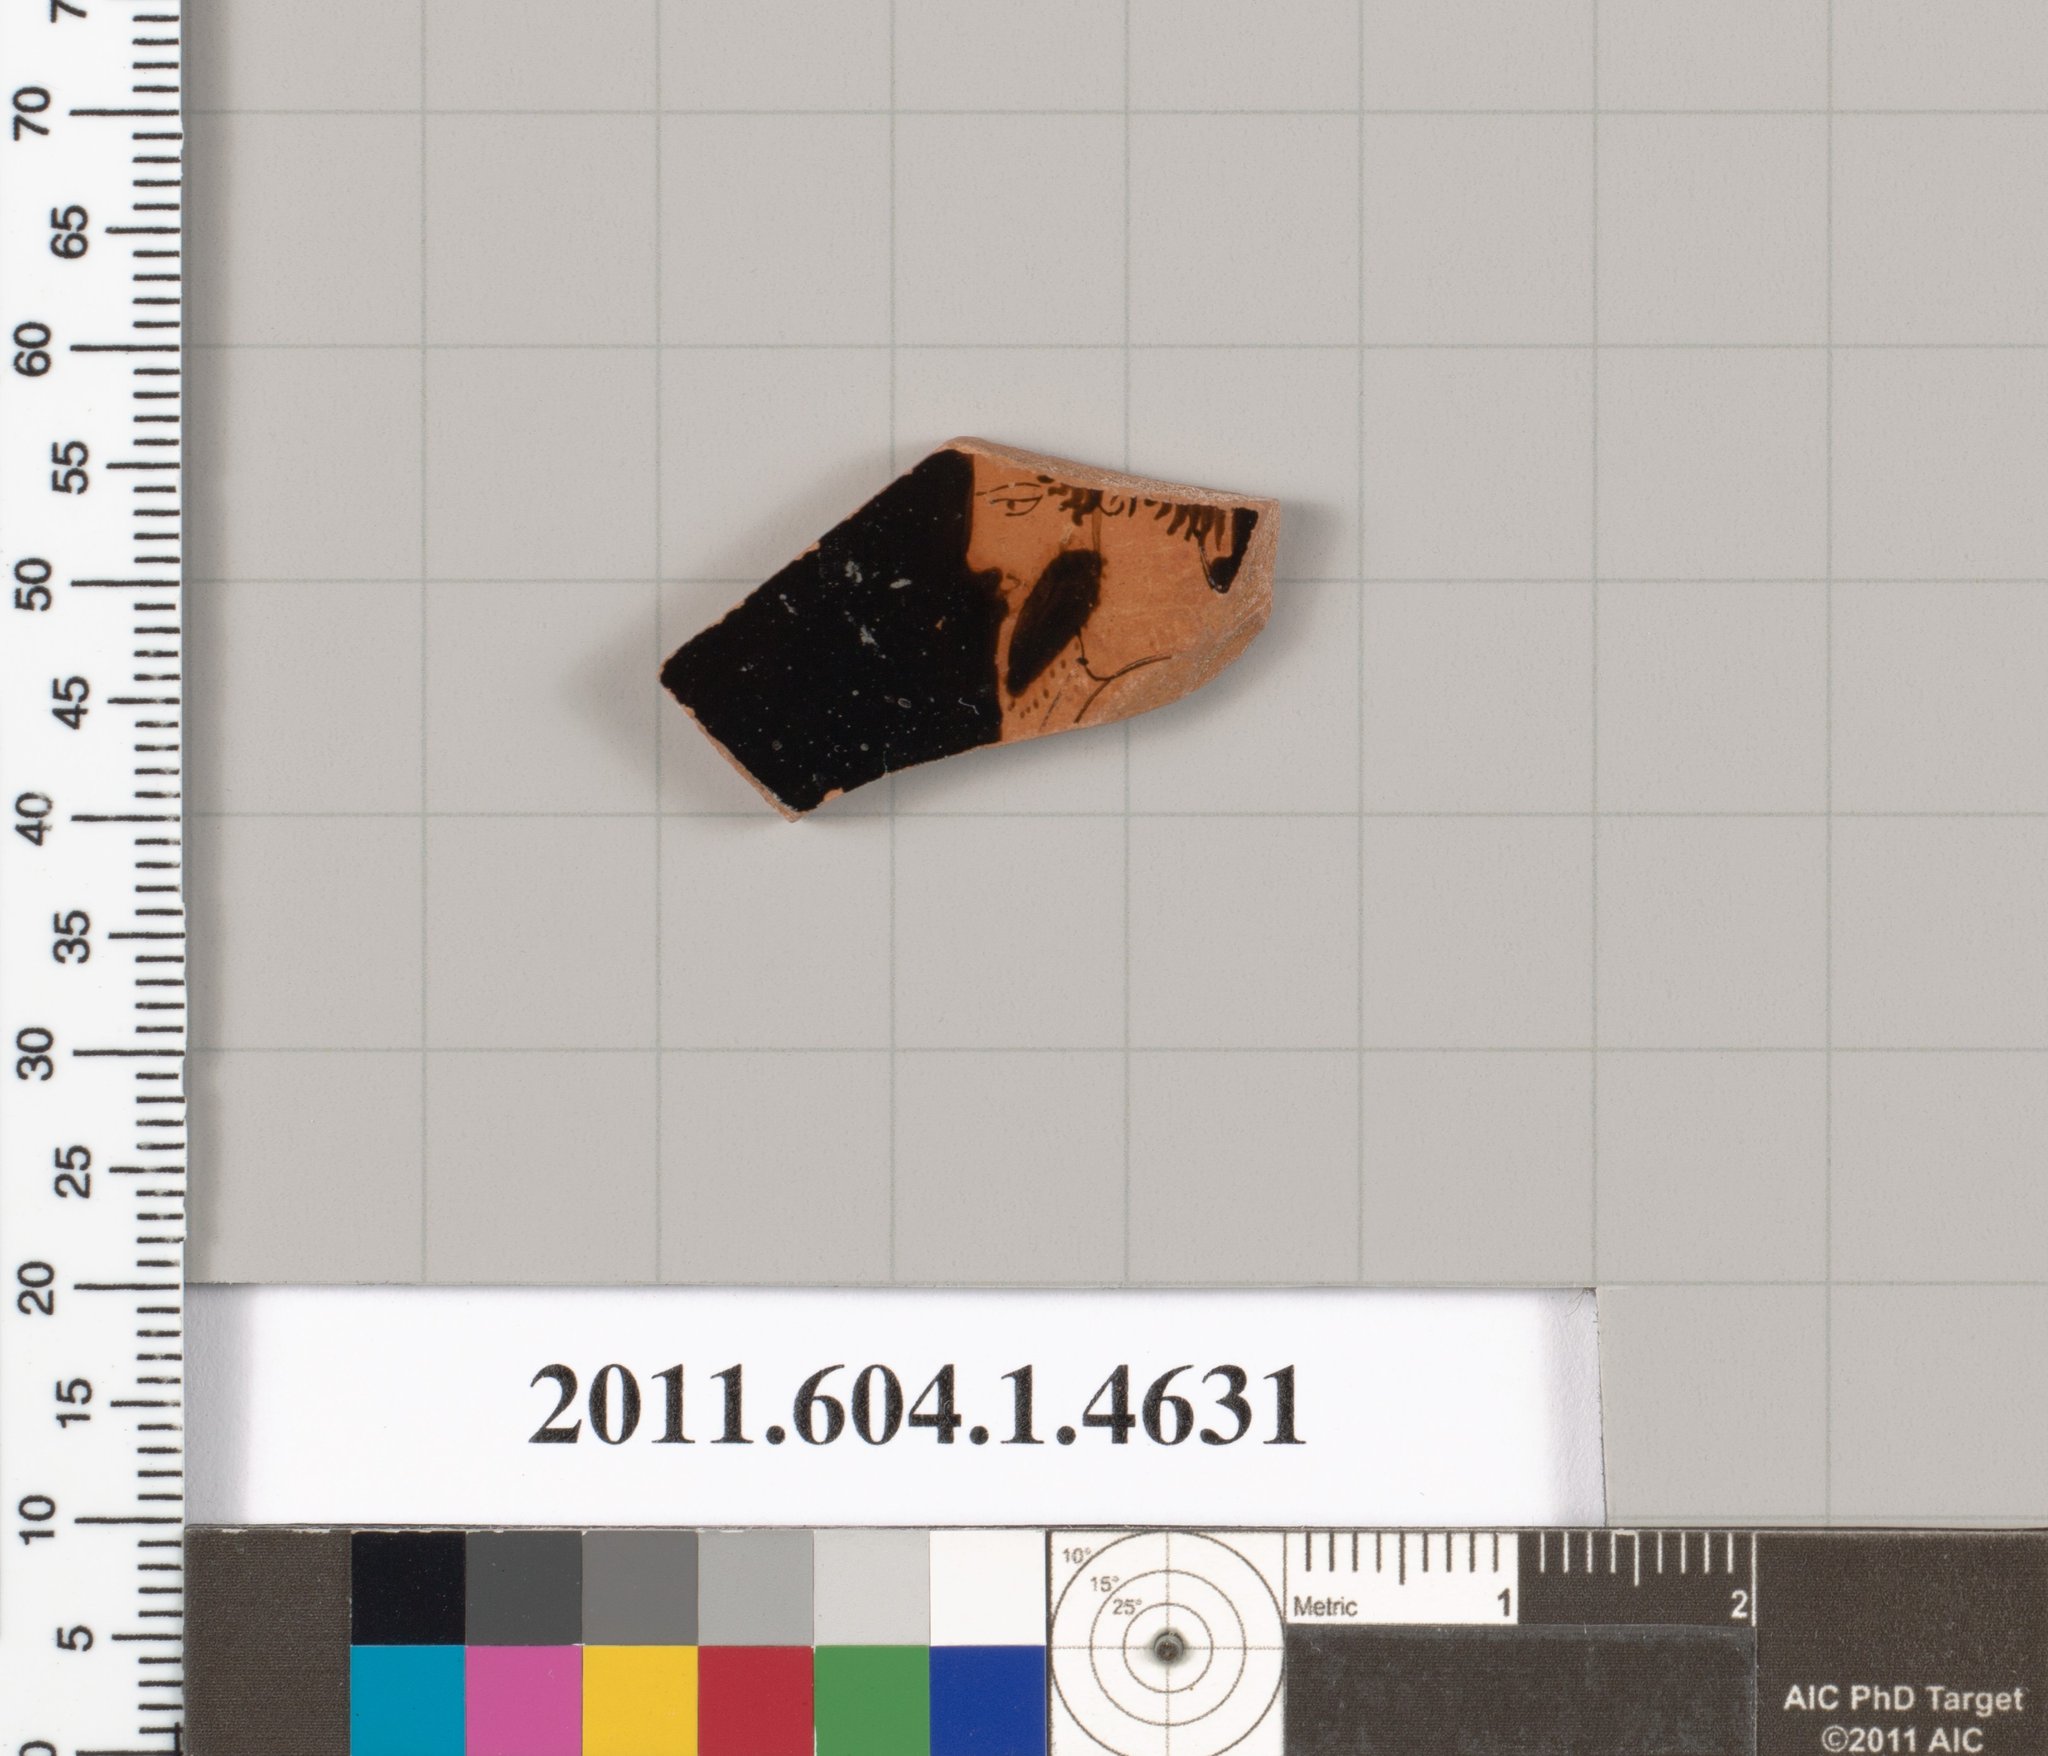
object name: kylix fragment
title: Terracotta fragment of a kylix (drinking cup)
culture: greek, attic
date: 470-460 BCE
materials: terracotta